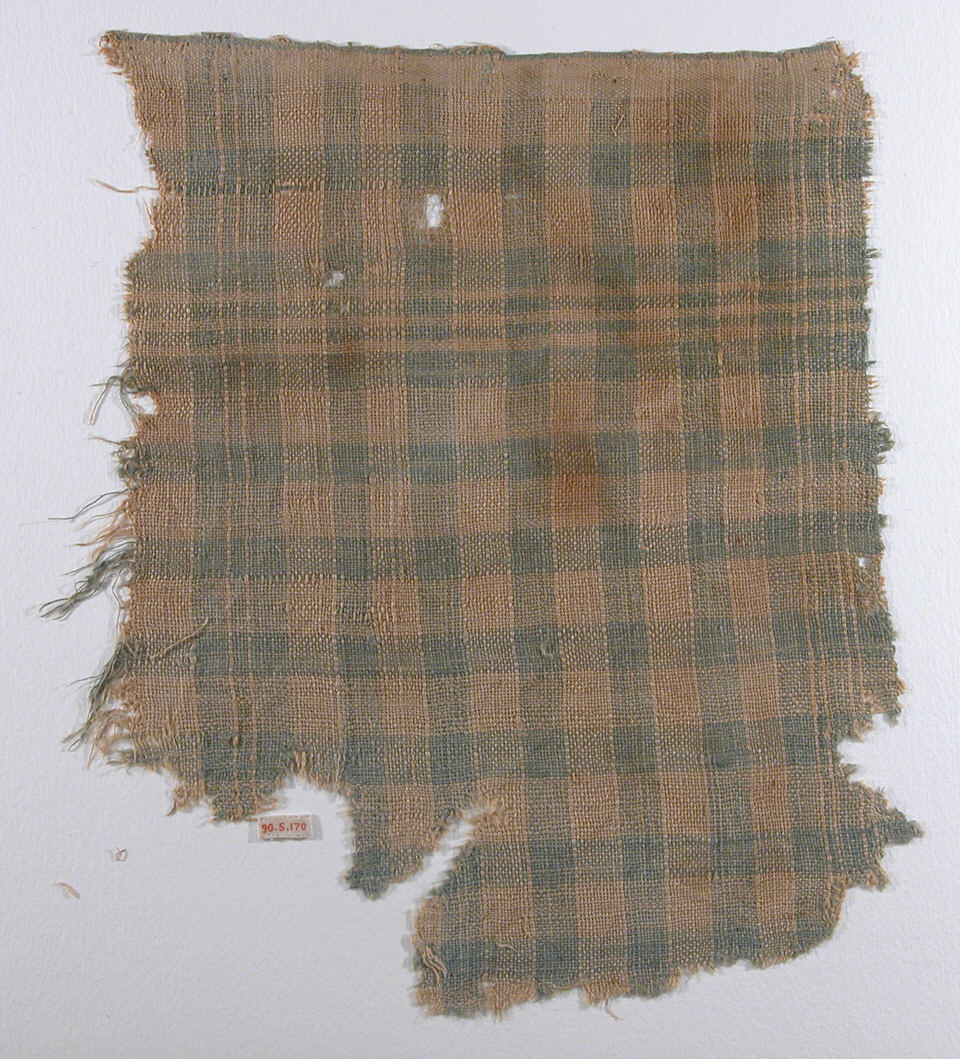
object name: textile fragment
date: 301-500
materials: linen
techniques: weave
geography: egypt